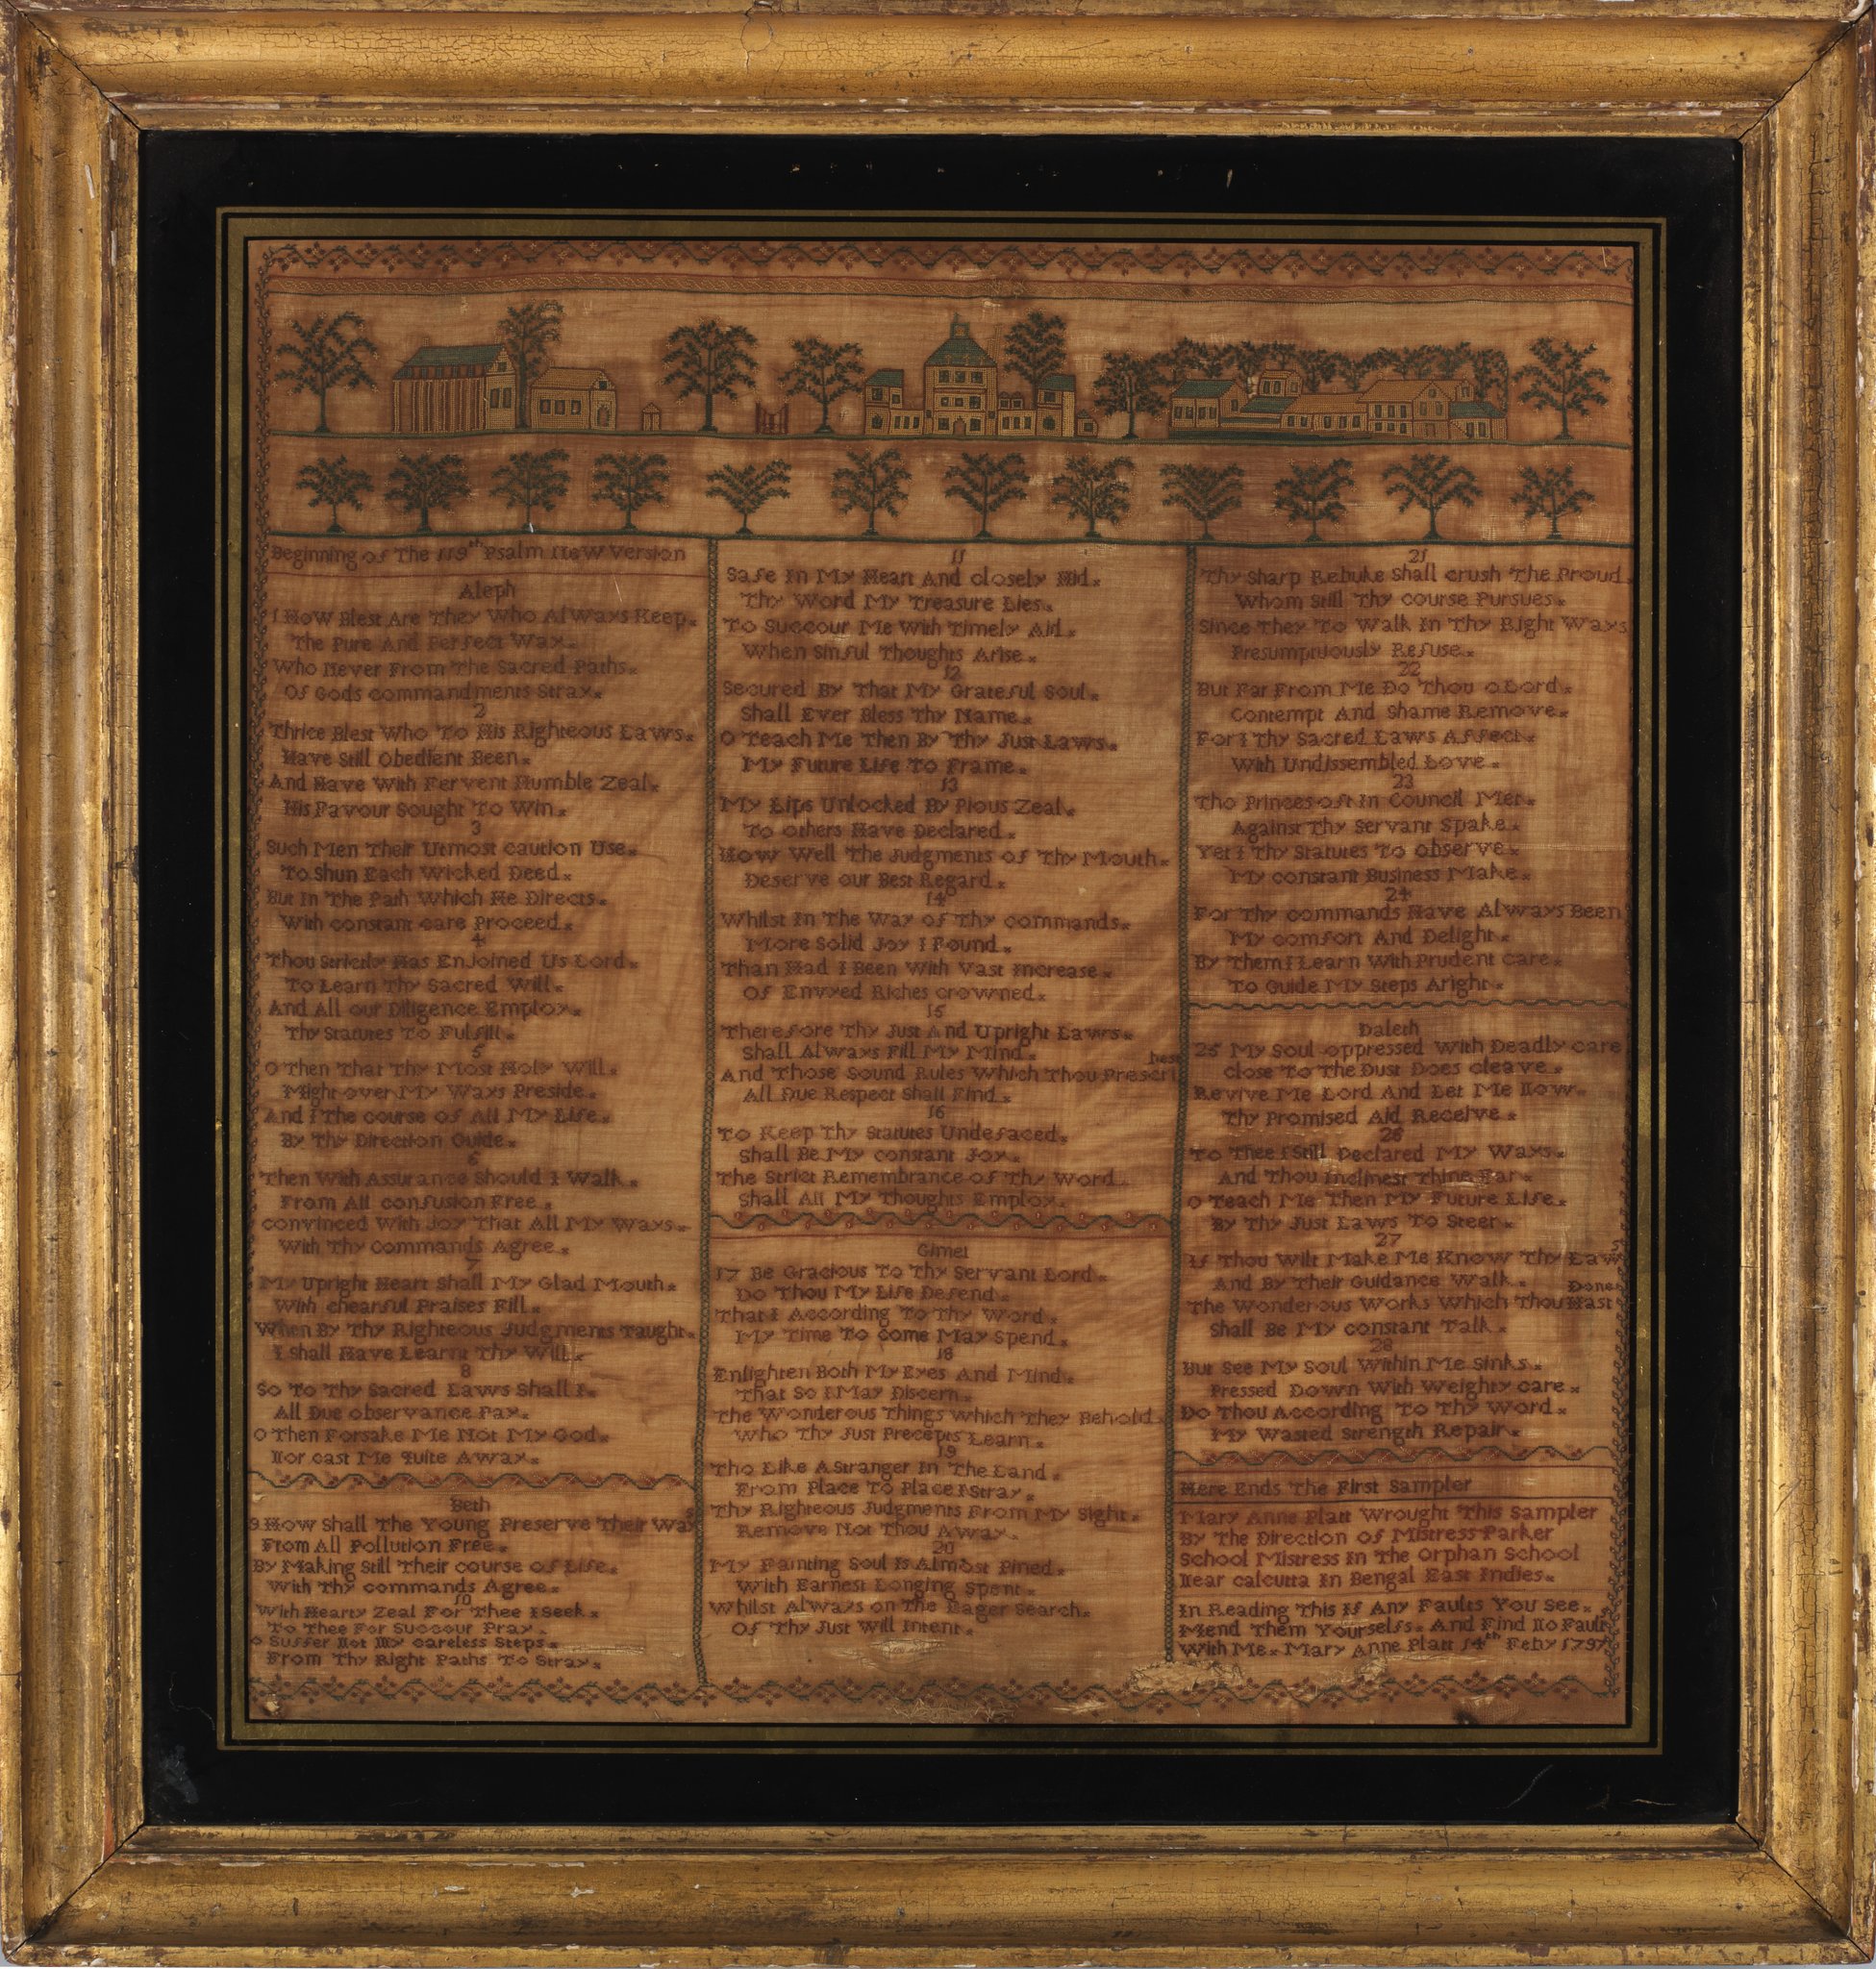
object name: sampler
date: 1797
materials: cotton, silk